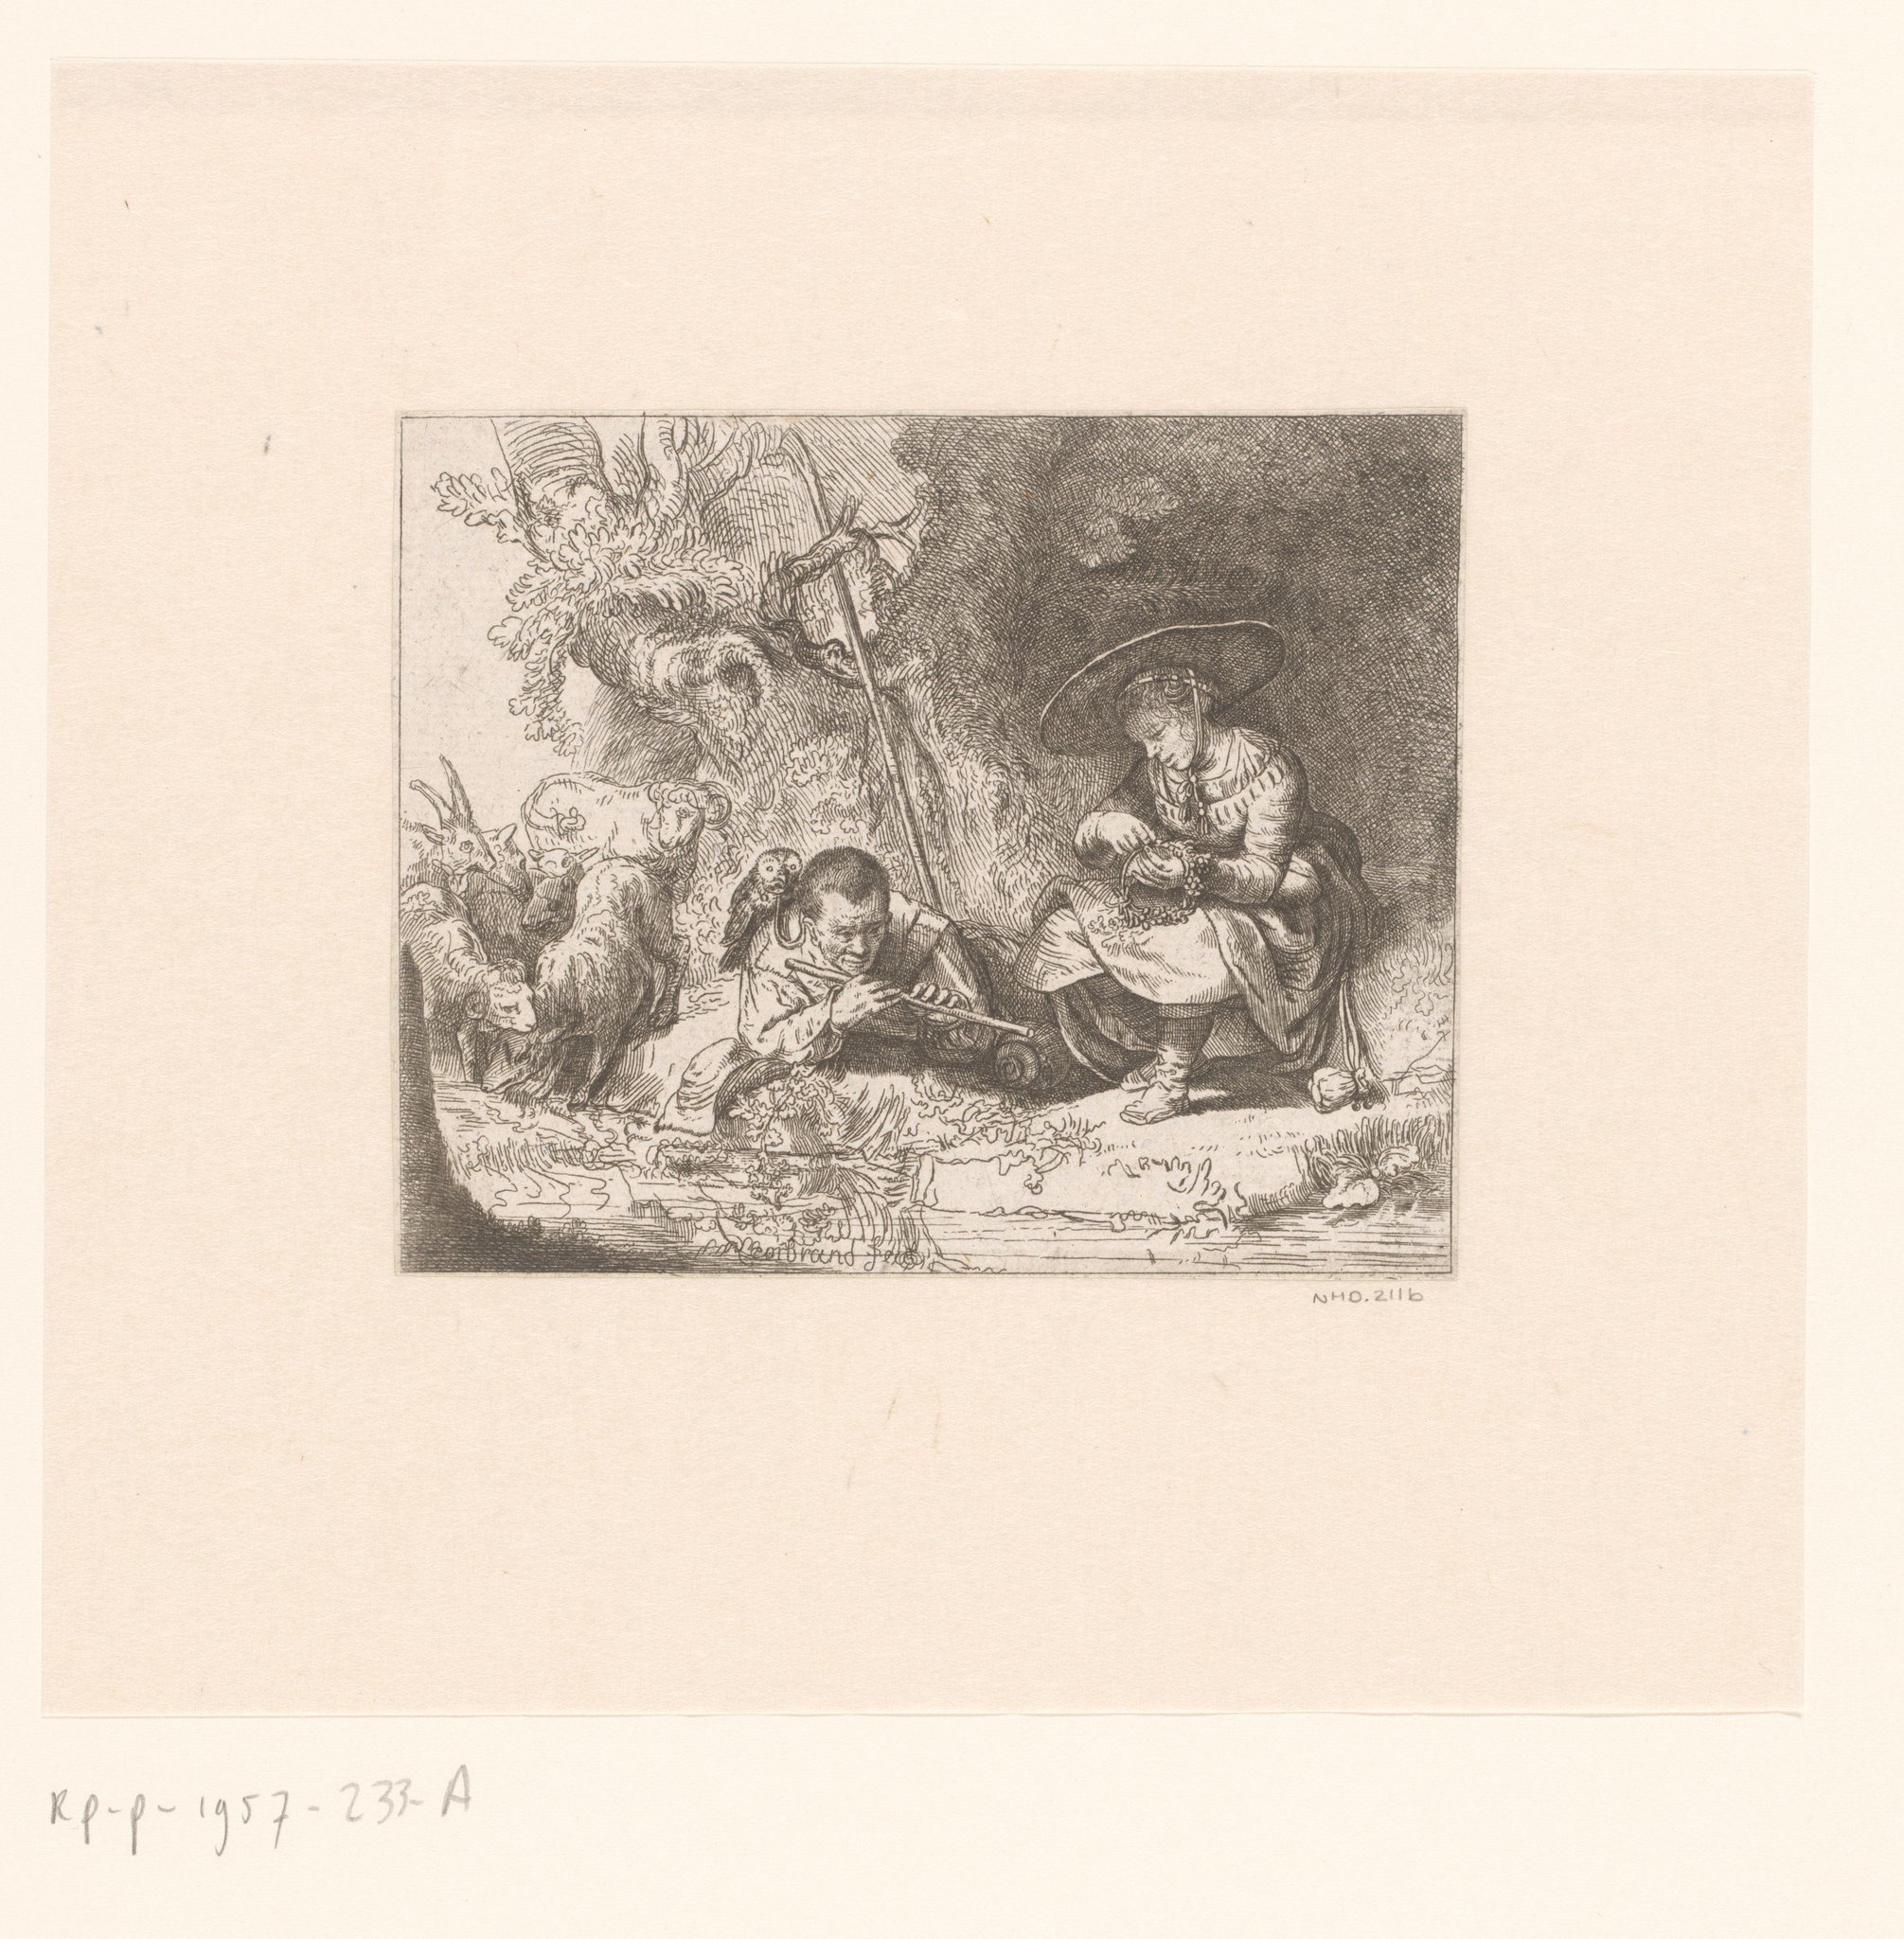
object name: print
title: The flute player ('Het Uilenspiegeltje')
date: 1711-1800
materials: paper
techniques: etching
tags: flute, aulos, tibia - cc - out of doors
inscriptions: collector's mark: Lugt 2760, collector's mark: Lugt 2228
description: Spiegelbeeldige kopie naar de gelijknamige prent van Rembrandt.